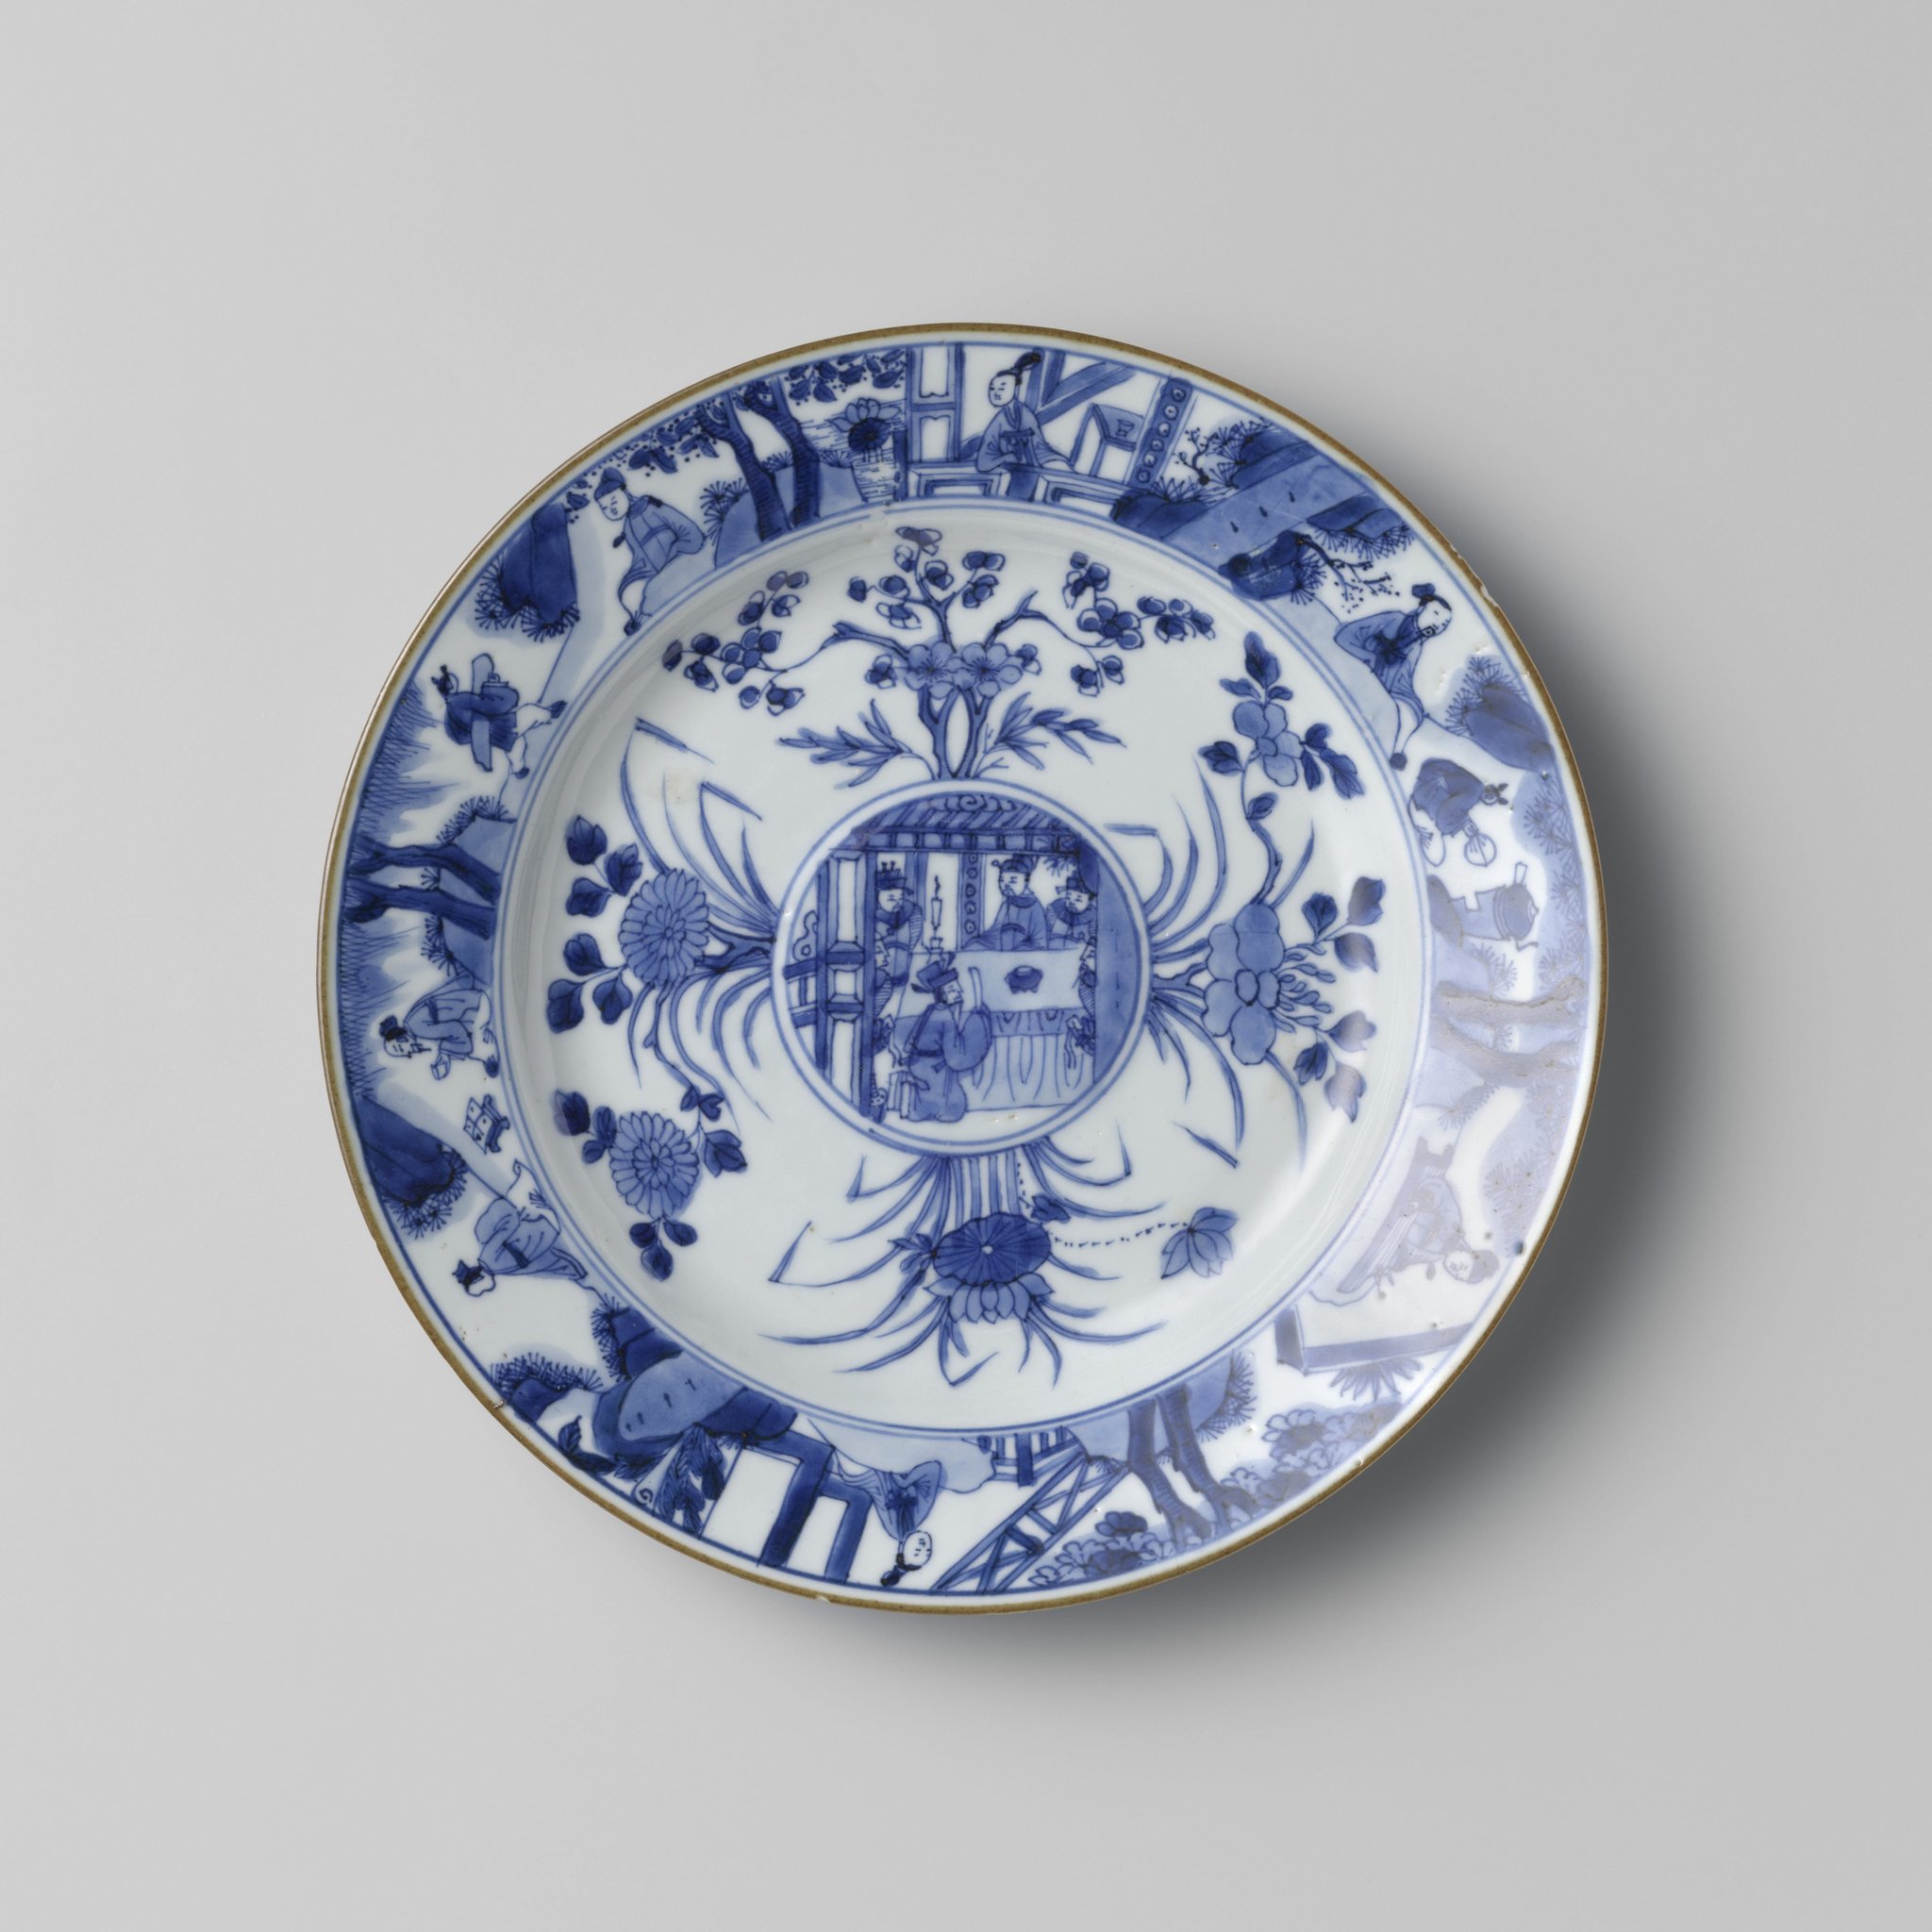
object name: plate dish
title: Plate with flower sprays and figures in an interior and in a landscape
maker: Anonymous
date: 1700-1724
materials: cobalt, glaze, paint, porcelain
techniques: firing, turning, vitrification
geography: china